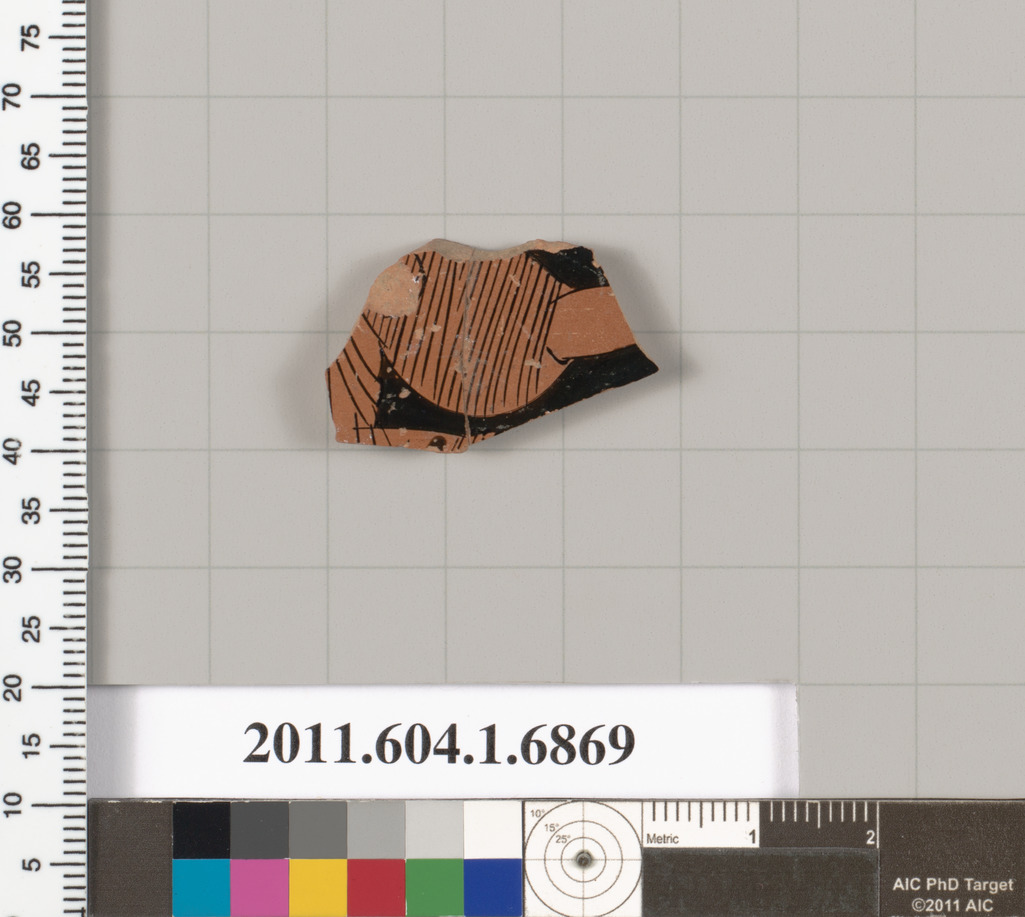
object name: kylix fragment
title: Terracotta fragment of a kylix (drinking cup)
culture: greek, attic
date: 490-470 BCE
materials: terracotta